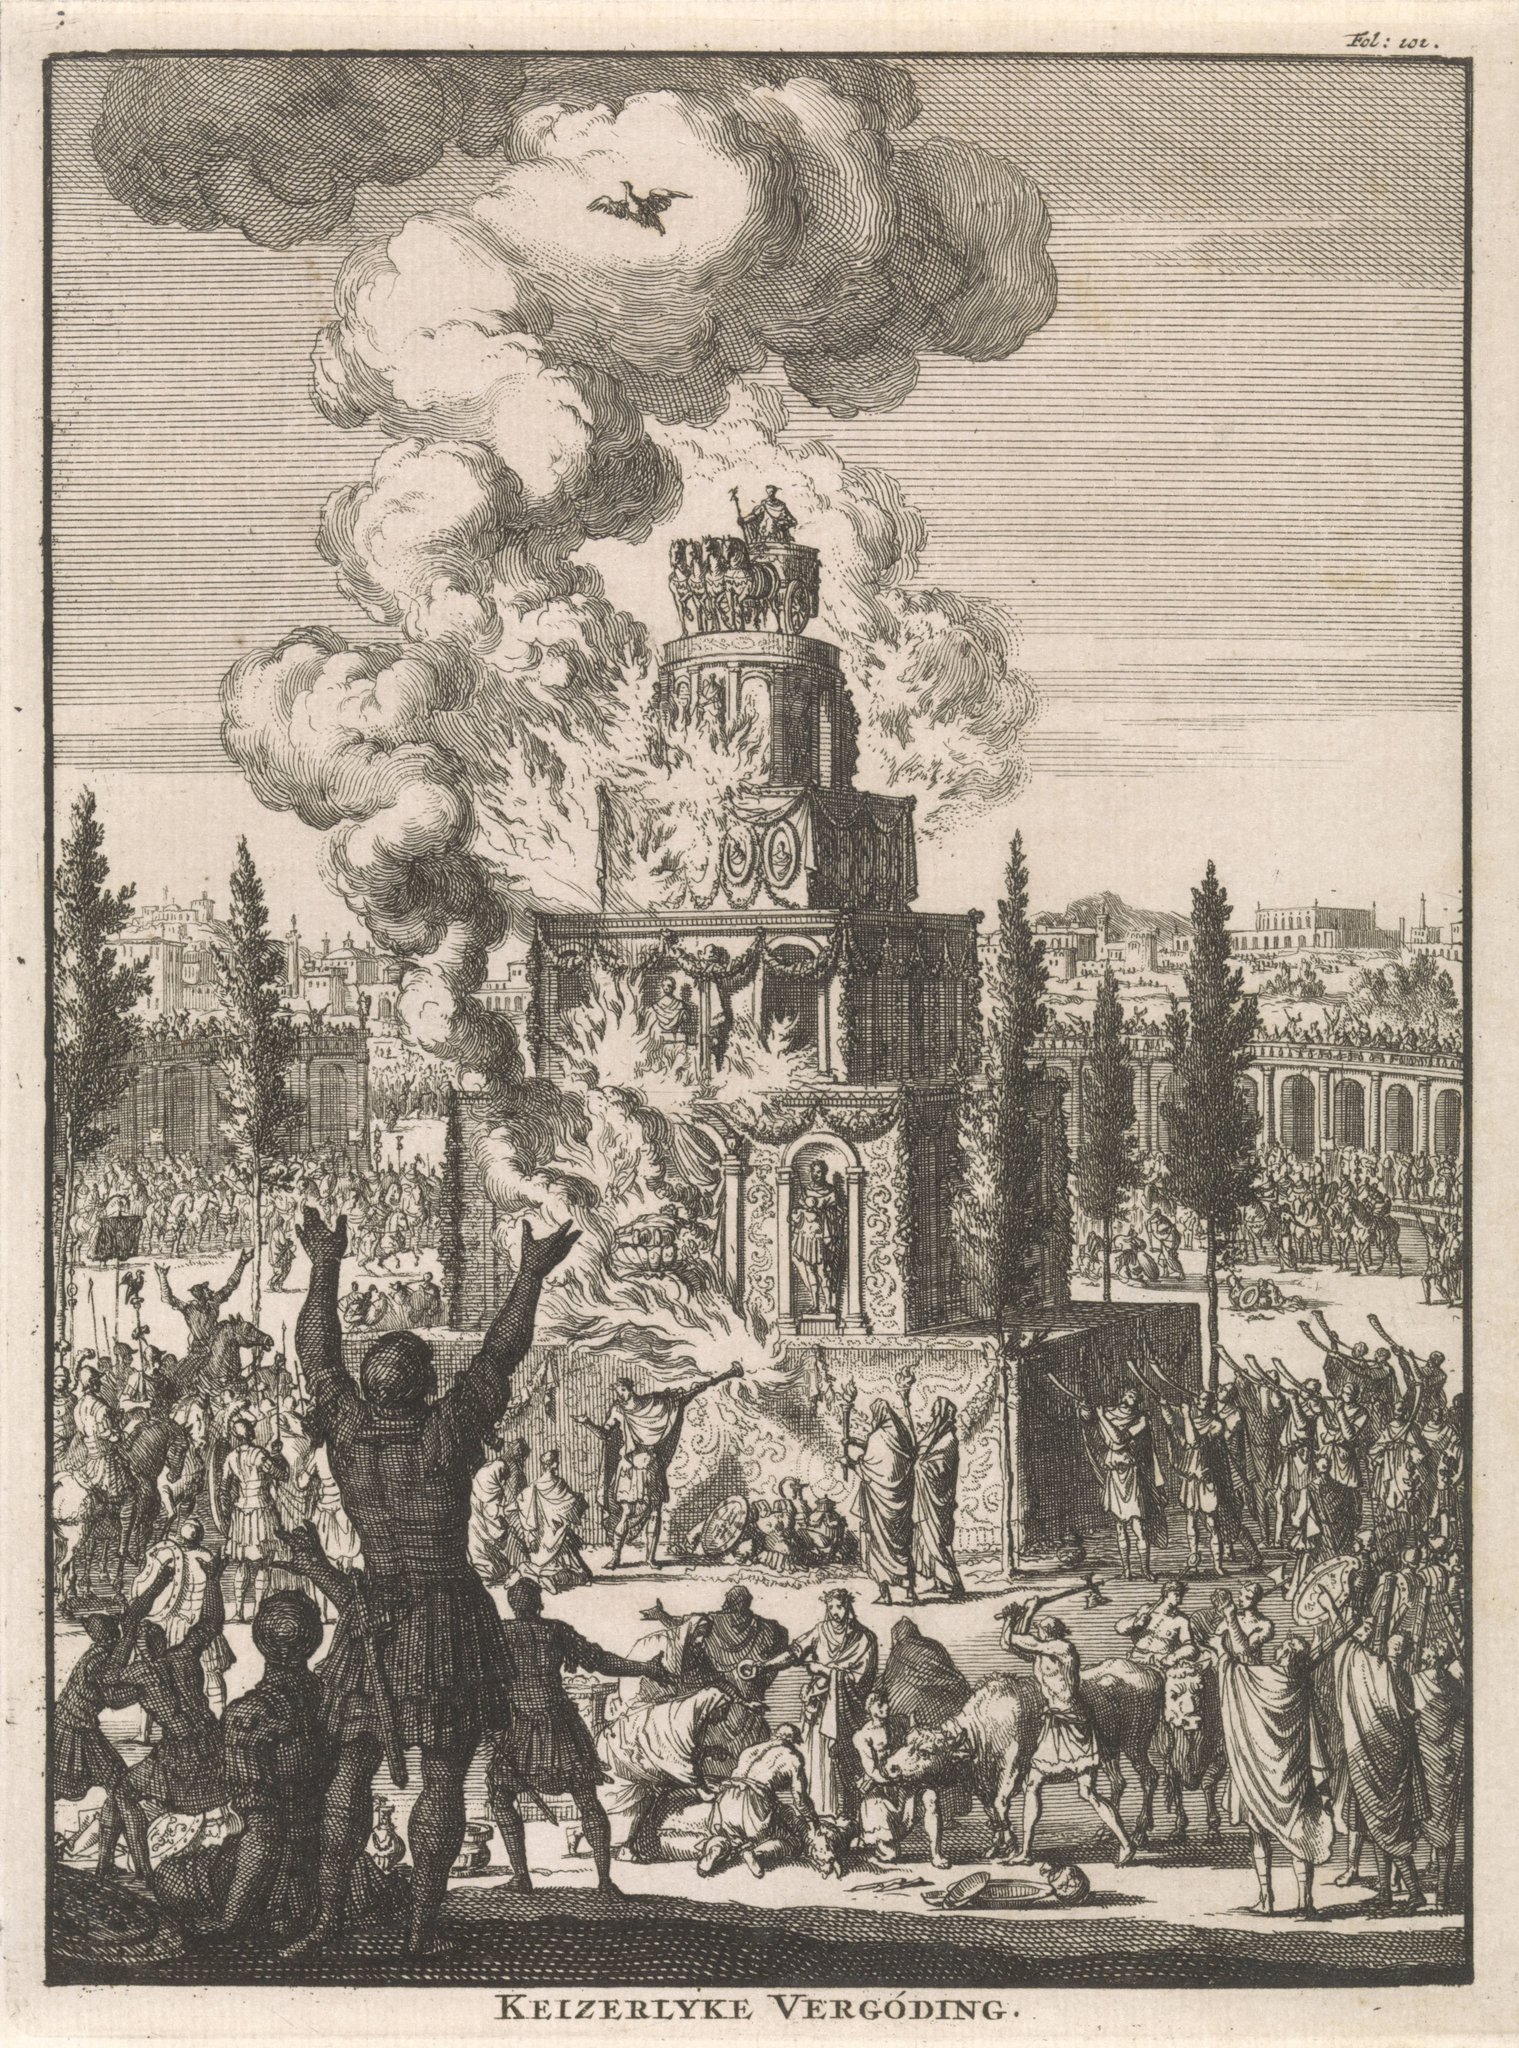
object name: print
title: Keizerlyke Vergoding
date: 1697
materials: paper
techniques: etching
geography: amsterdam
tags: ritual practices ~ roman religion, predatory birds: eagle, violent death by burning at the stake; pyre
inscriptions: collector's mark: Lugt 2228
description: Illustratie uit: Bogaert, Abraham. De roomsche monarchy, vertoont in de muntbeelden der westersche en oostersche keizeren. Utrecht: François Halma en Willem van de Water, 1697.